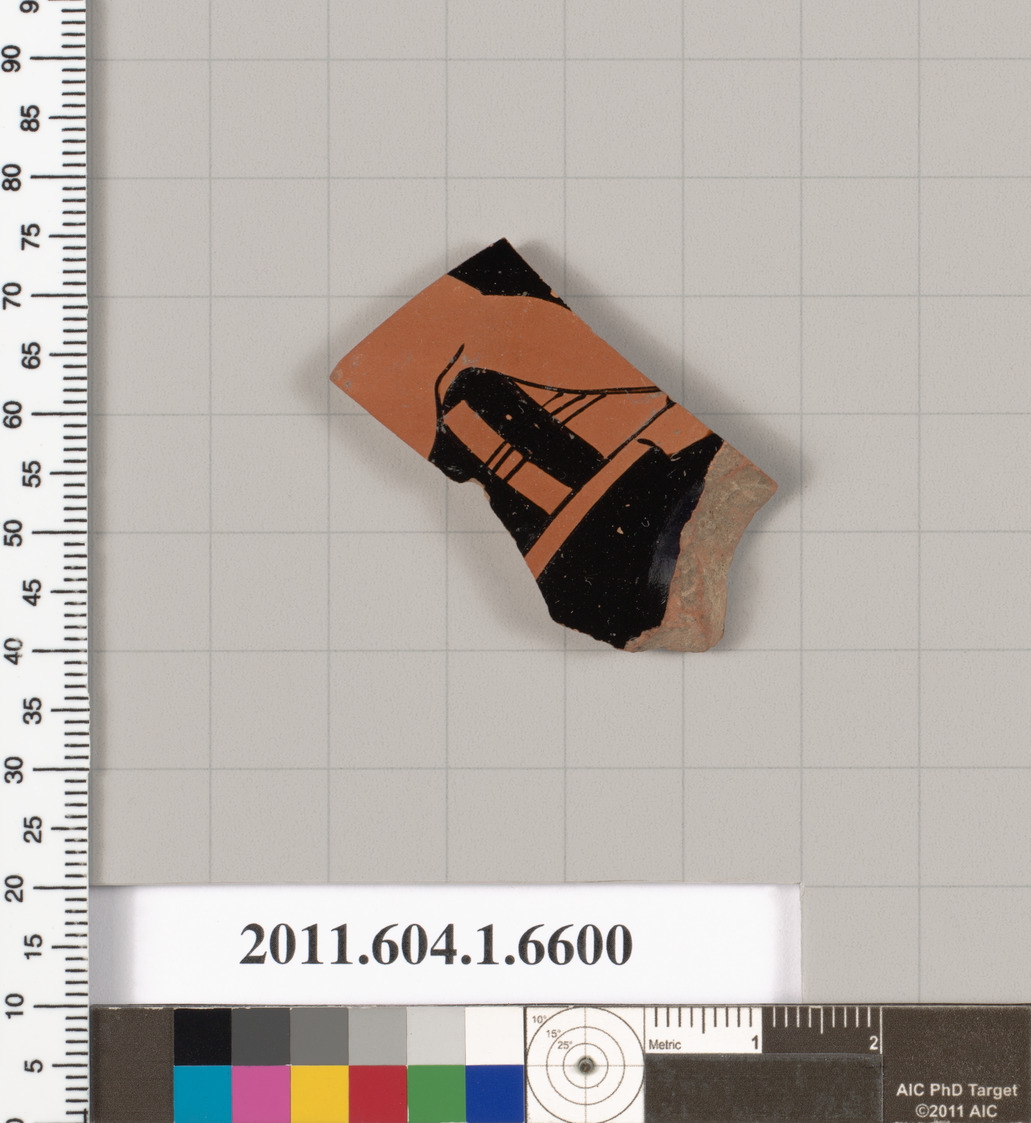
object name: kylix fragment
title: Terracotta fragment of a kylix (drinking cup)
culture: greek, attic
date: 490-480 BCE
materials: terracotta